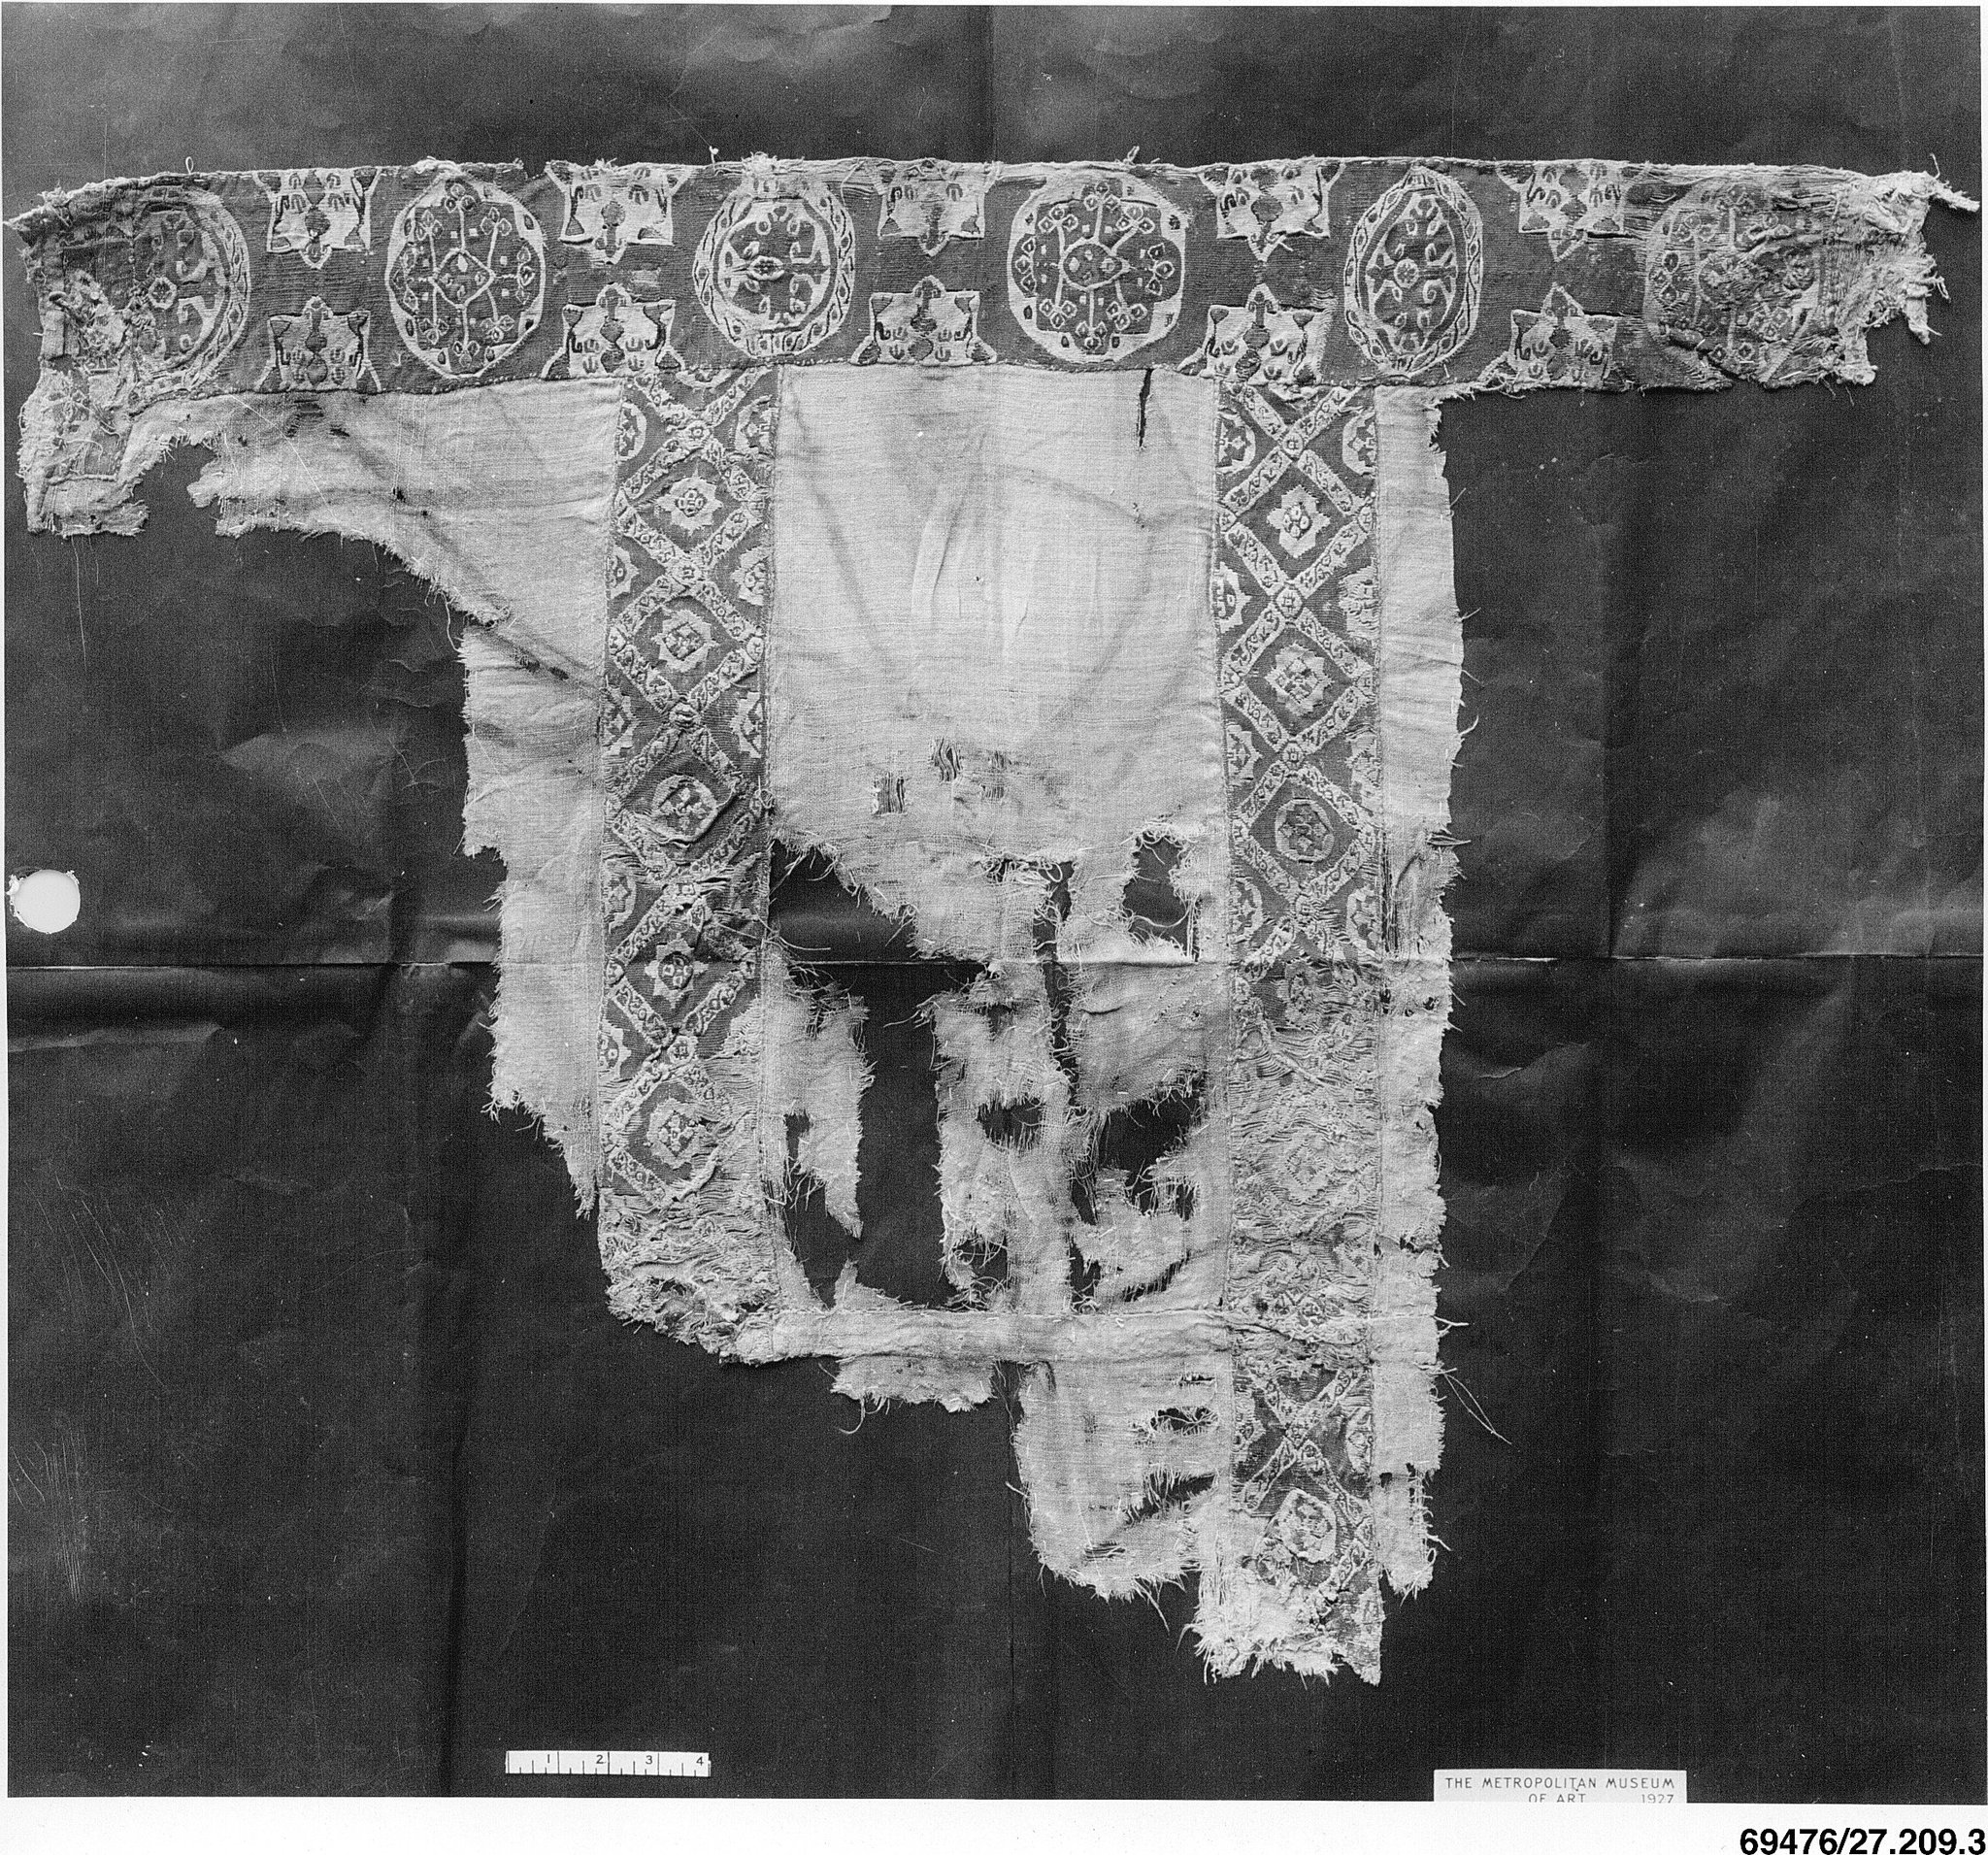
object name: tunic fragment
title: Fragment of a Tunic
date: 501-700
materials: linen, wool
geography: egypt